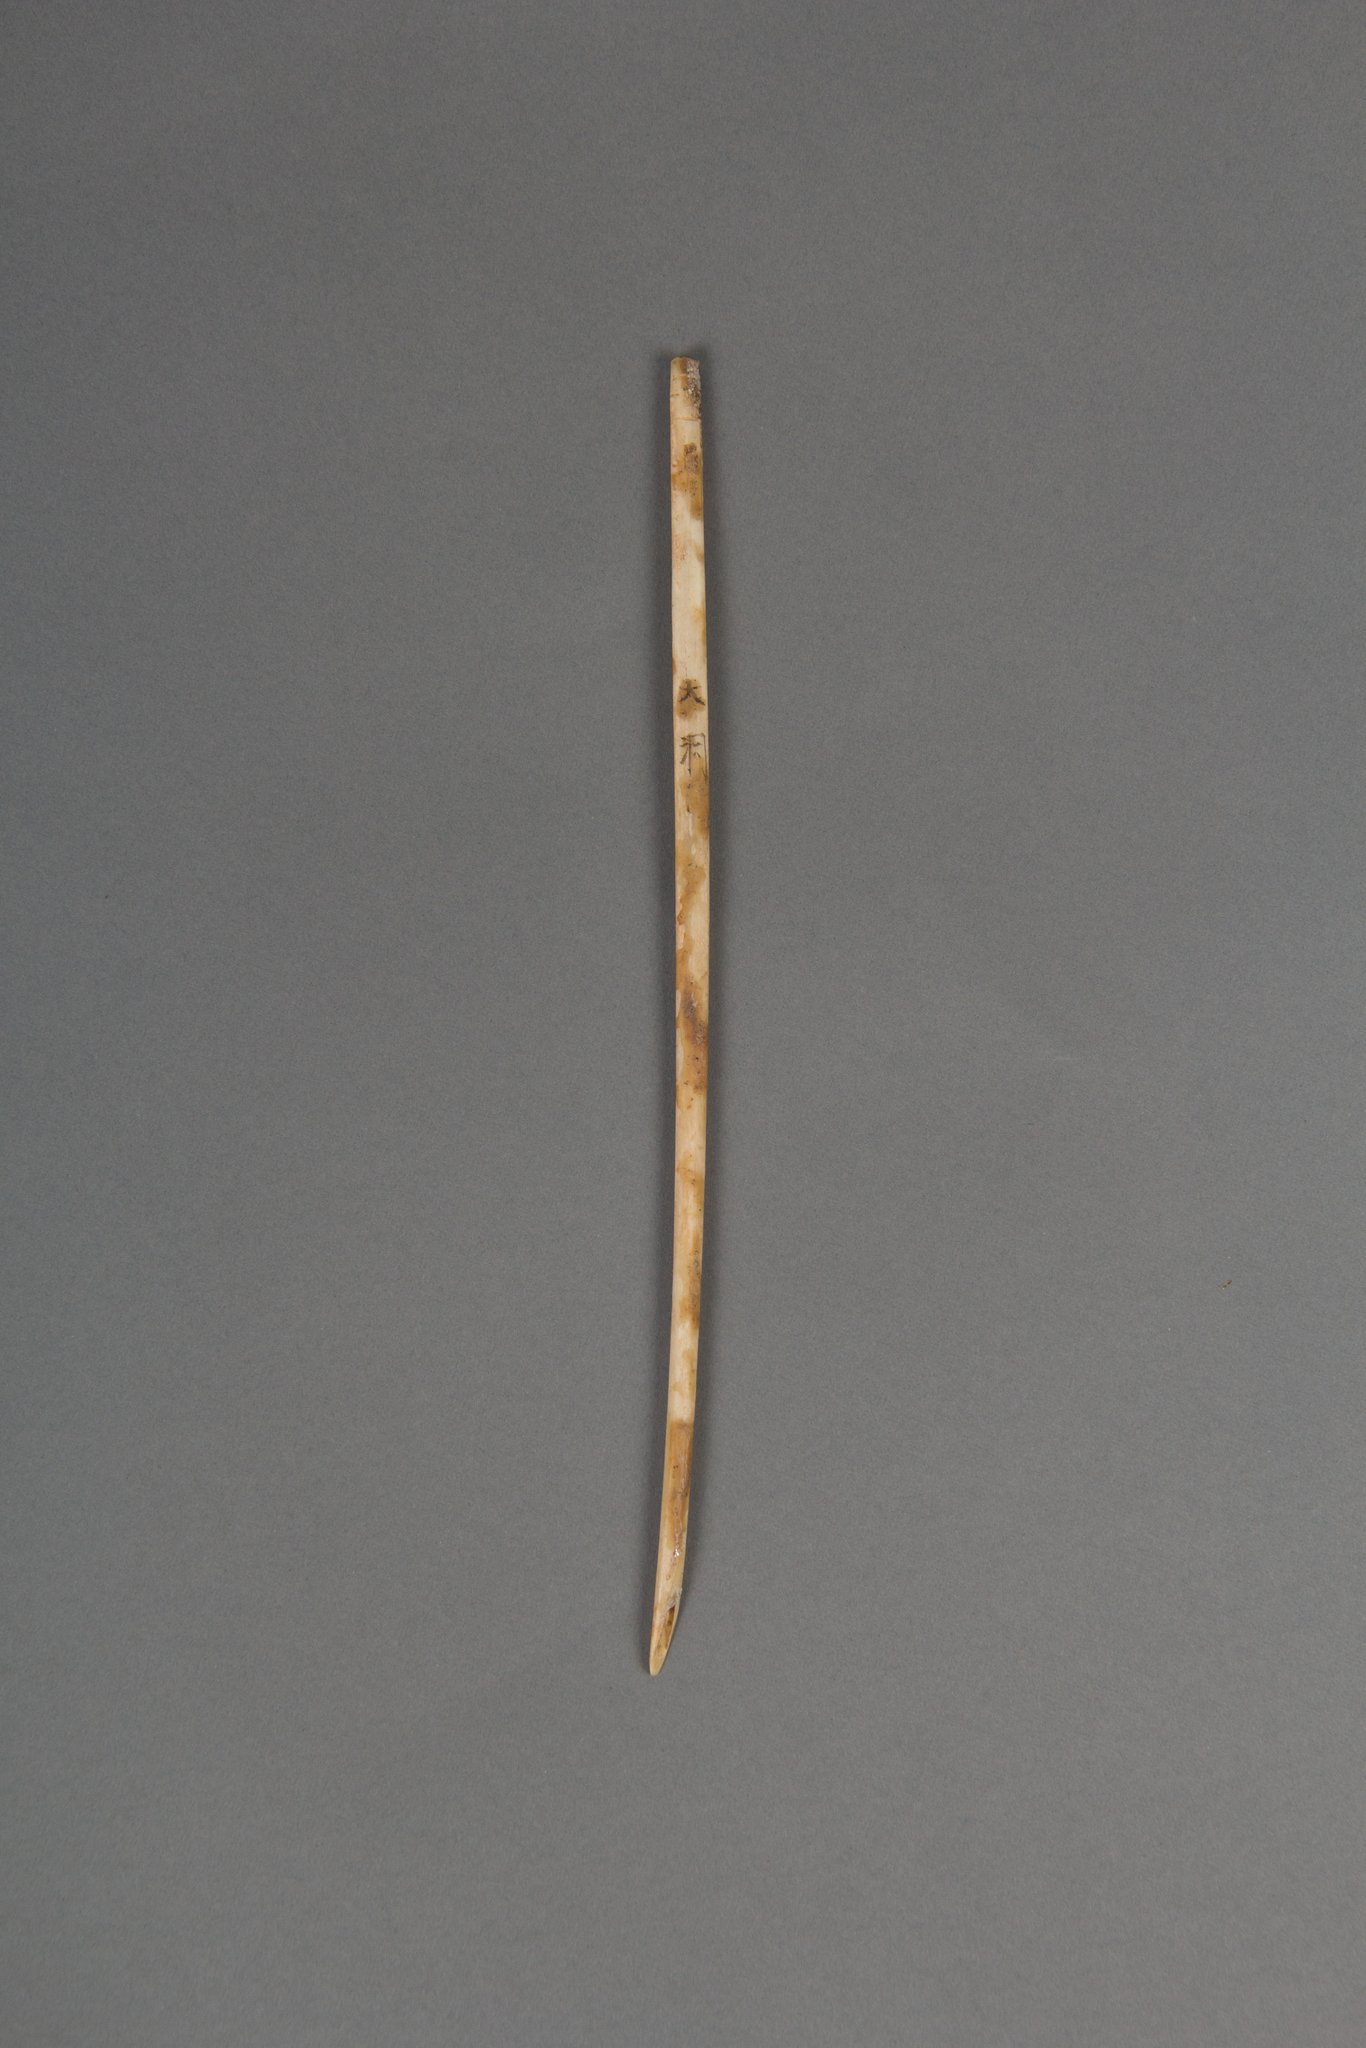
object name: needle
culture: japanese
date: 1200-200 BCE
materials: bone